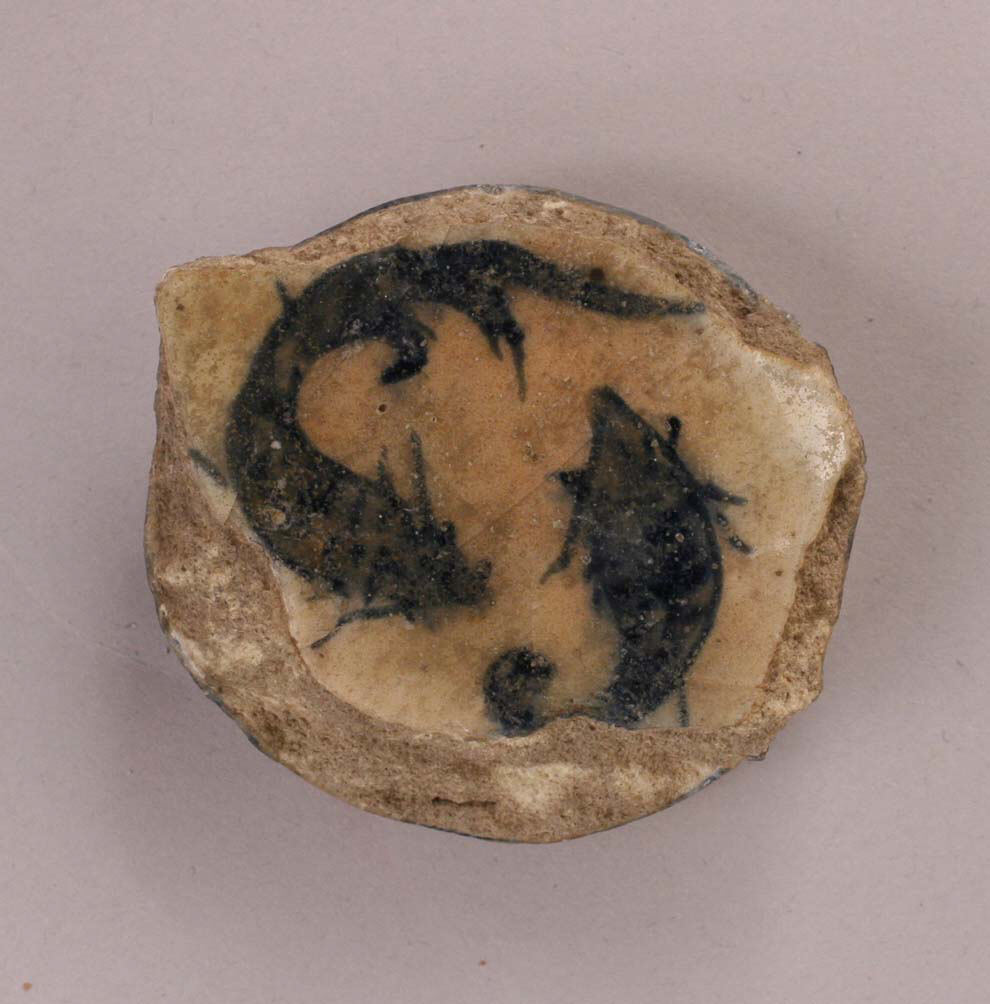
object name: fragment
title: Ceramic Fragment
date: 1301-1500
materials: stonepaste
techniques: painting, underglaze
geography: egypt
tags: fish